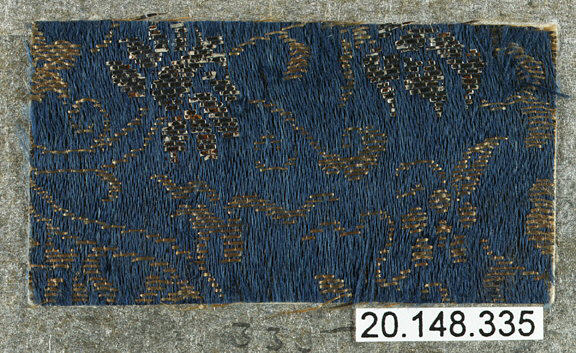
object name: piece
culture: japanese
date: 1601-1700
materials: silk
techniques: compound weave